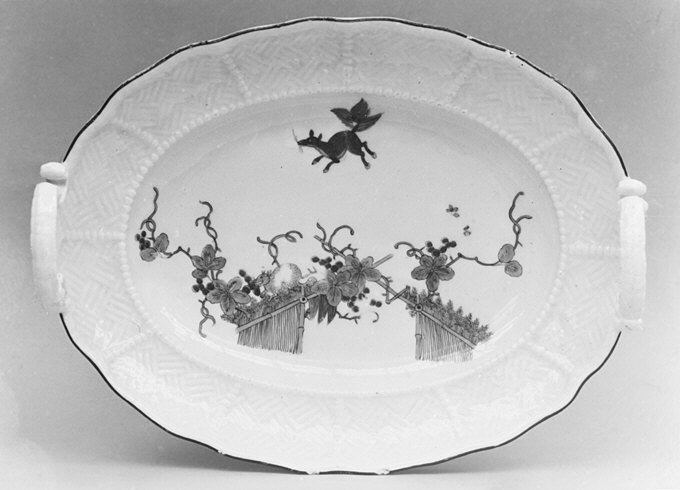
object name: tray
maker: meissen manufactory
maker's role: manufactory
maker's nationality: german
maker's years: 1710-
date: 1740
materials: hard paste porcelain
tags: mice